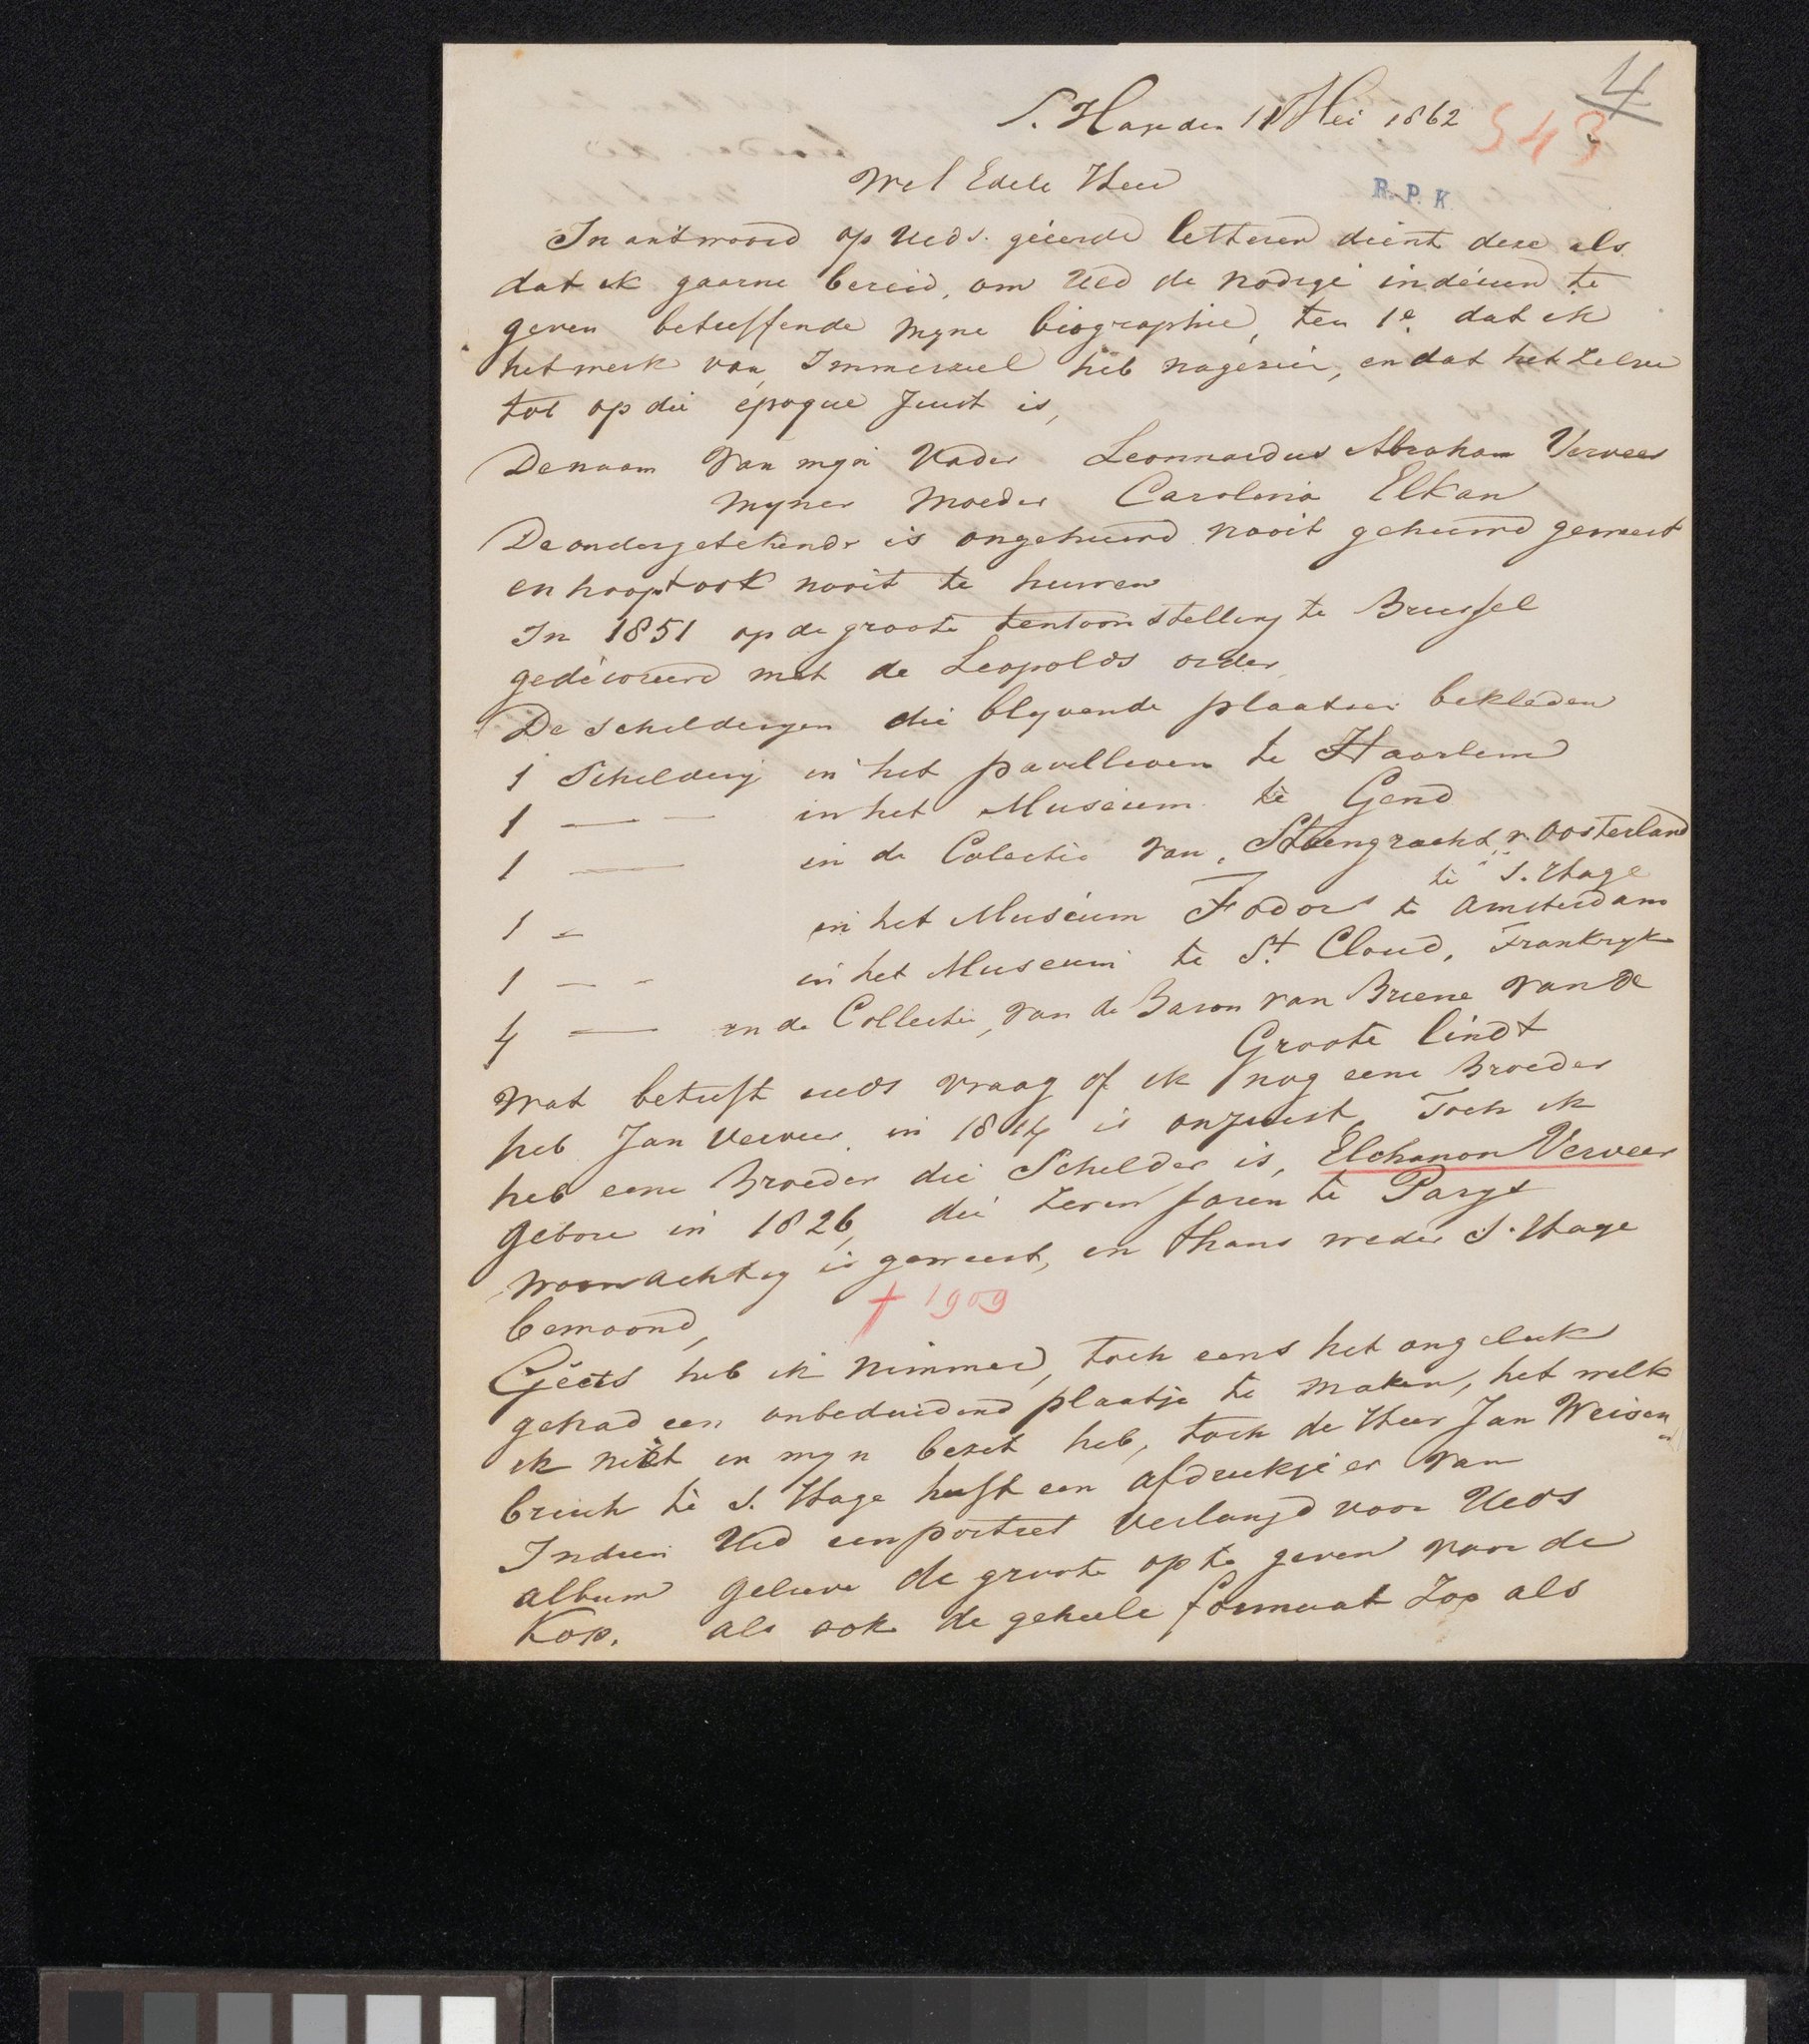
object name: letter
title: Brief aan Christiaan Kramm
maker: salomon leonardus verveer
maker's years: 1813-1876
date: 1862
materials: ink, paper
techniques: pen, writing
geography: the hague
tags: the hague, painter, jan weissenbruch, elchanon verveer, utrecht, print maker, draughtsman, christiaan kramm, distribution of awards ~ art contest, photography, cinematography, the graphic arts, painting (including book-illumination, miniature-painting), exhibition ~ art, historical persons (portraits and scenes from the life), brussels, paris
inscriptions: seal, collector's mark: Lugt 2233